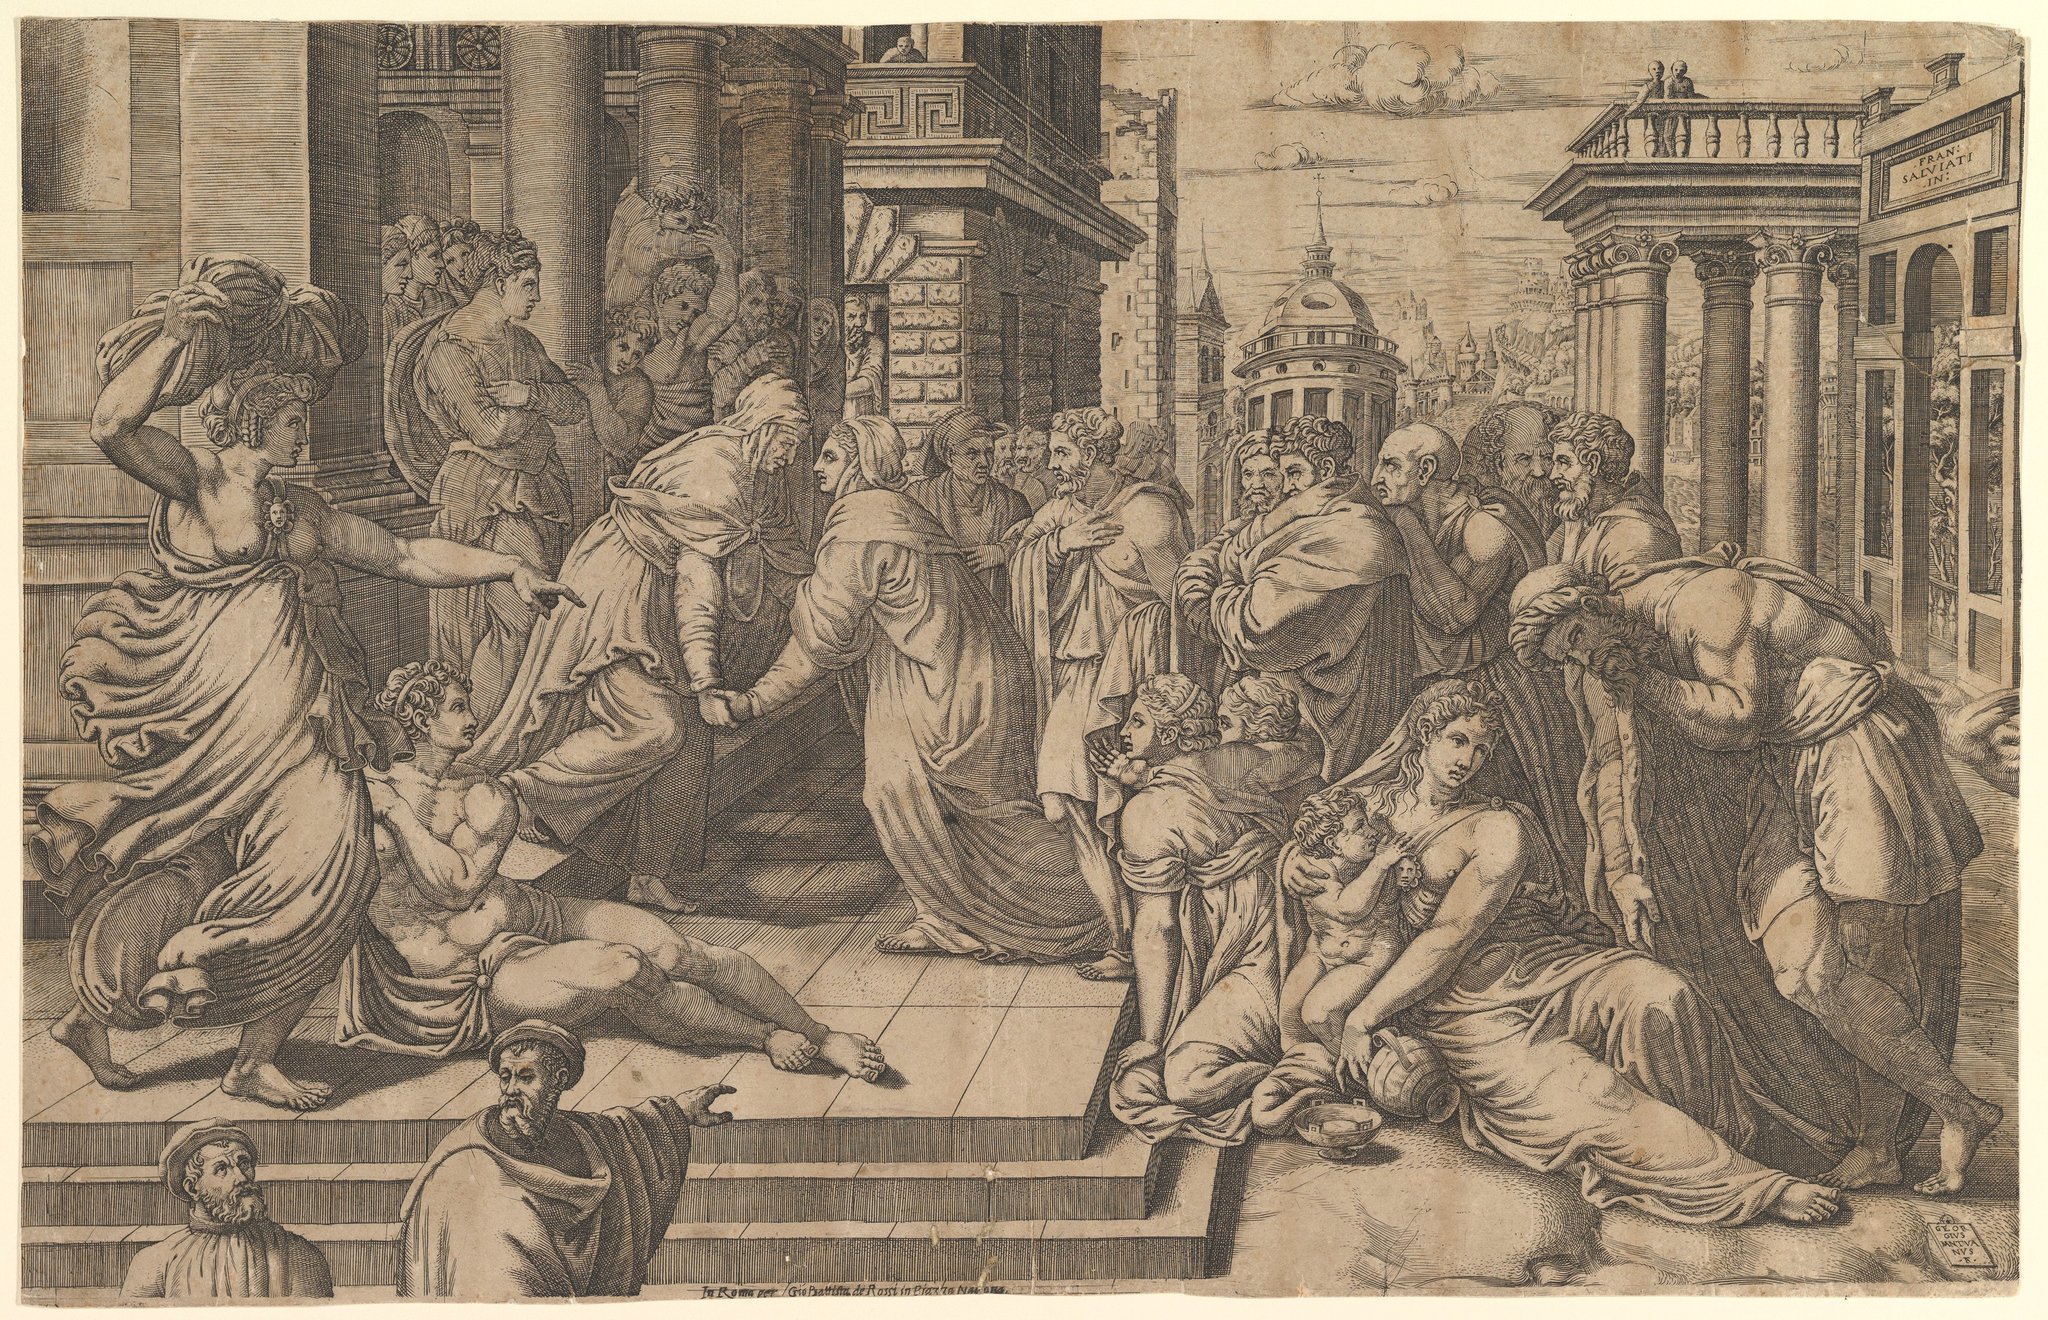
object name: print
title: The Visitation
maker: giorgio ghisi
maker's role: artist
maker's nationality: italian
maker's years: 1515-1582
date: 1540-1550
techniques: engraving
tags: buildings,men,women,virgin mary